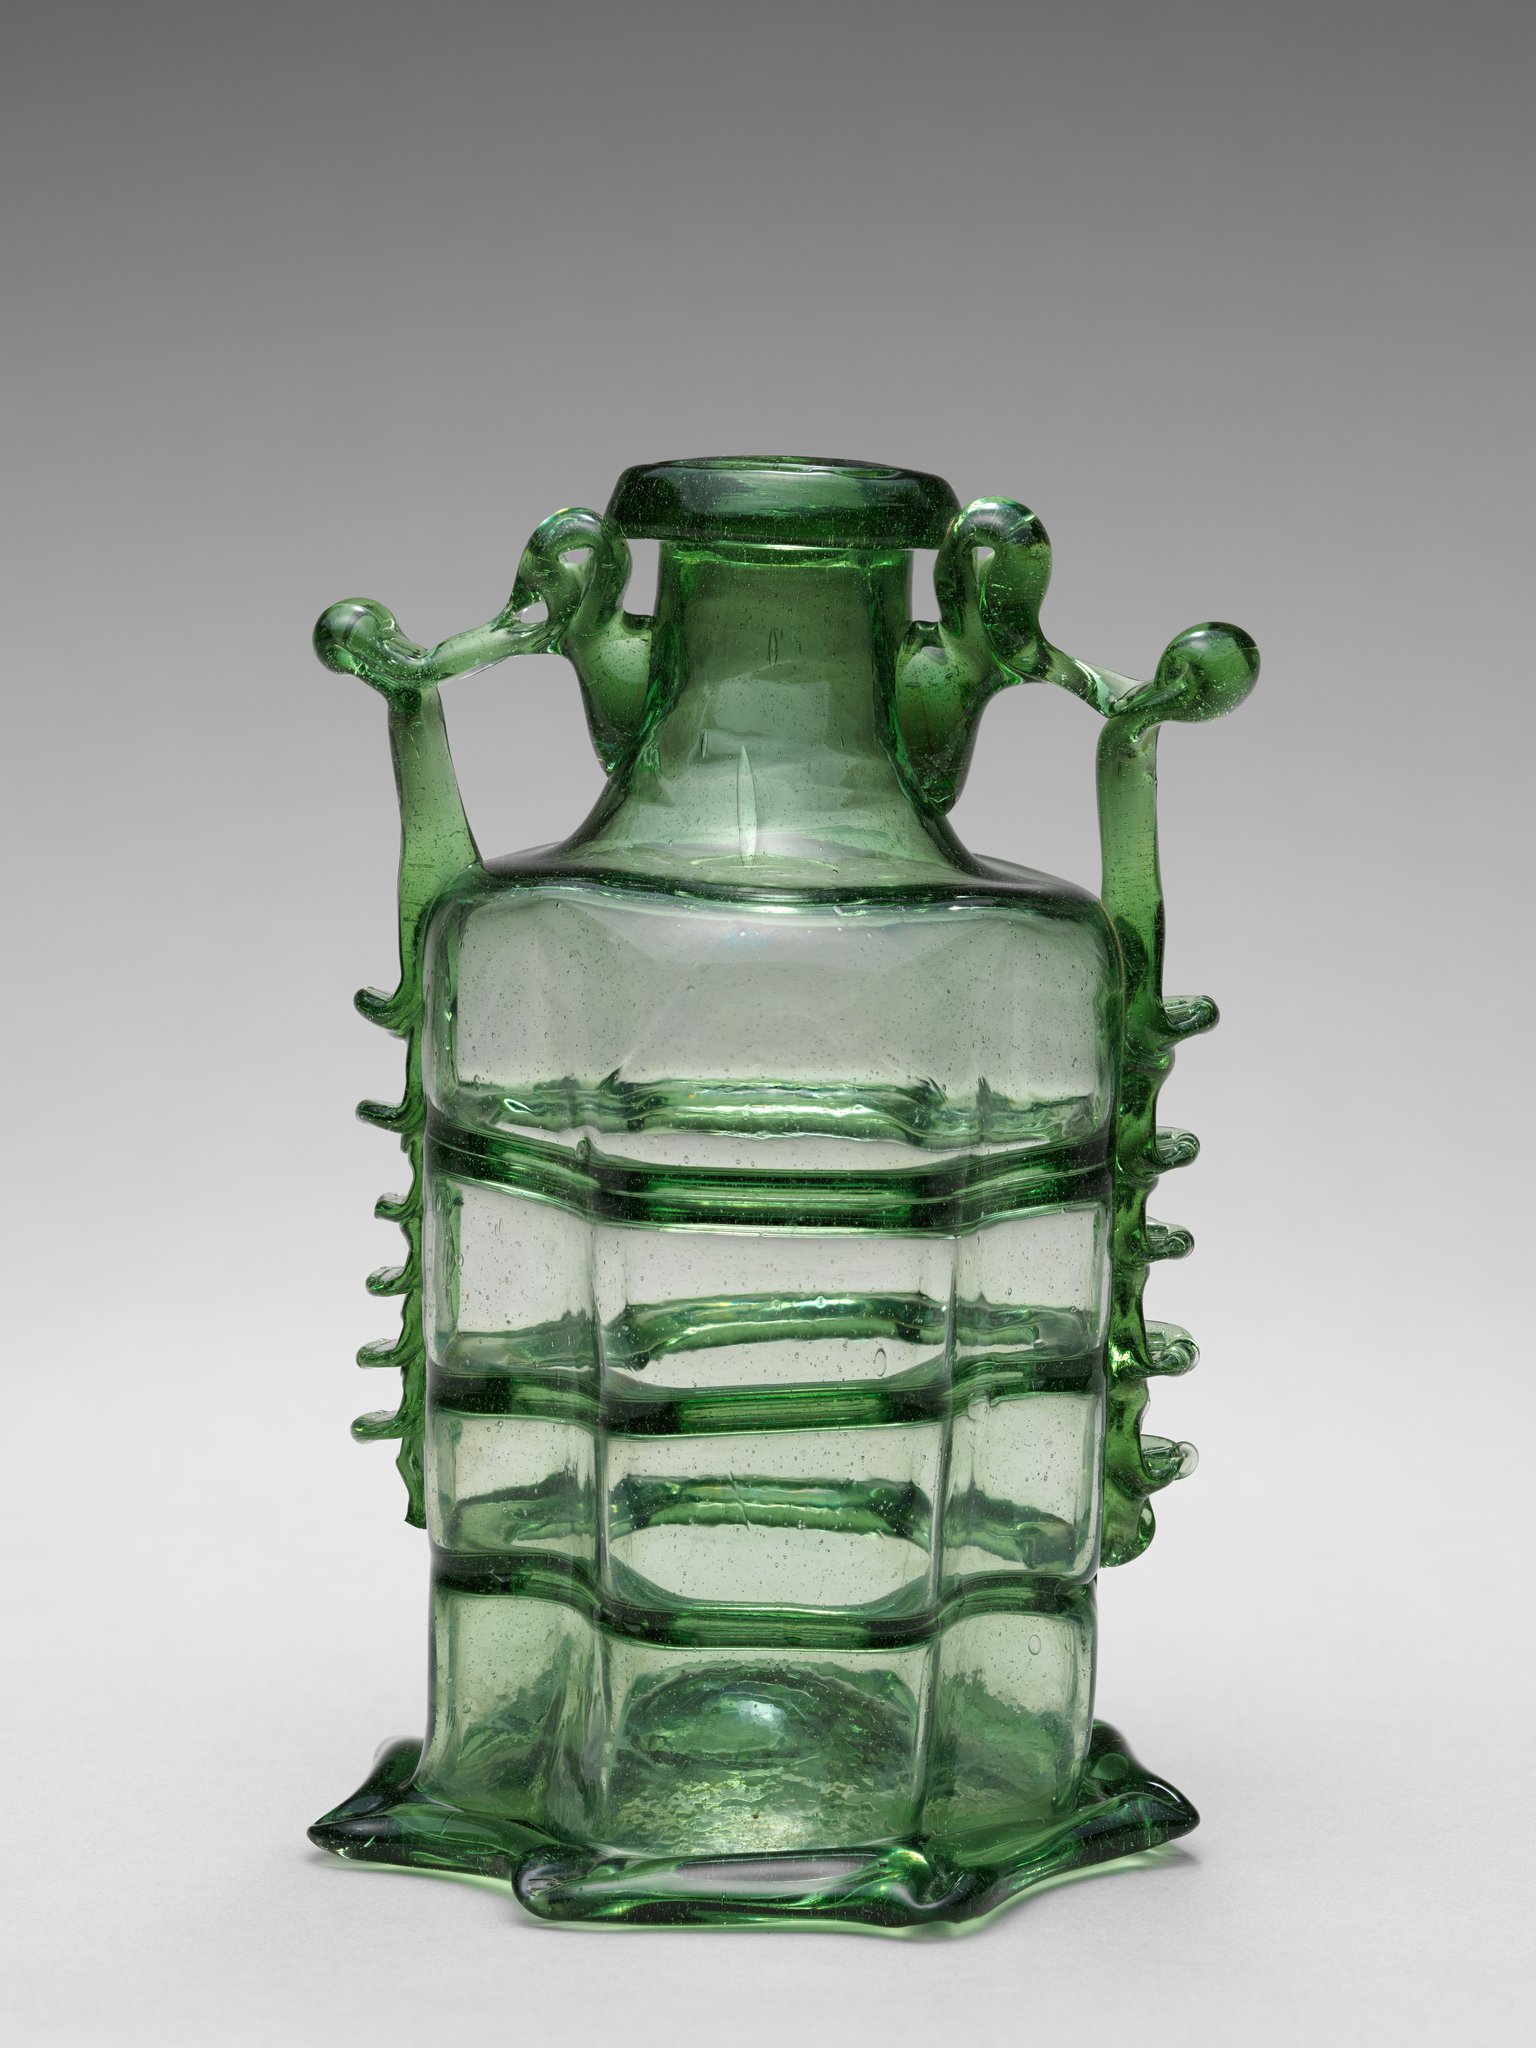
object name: bottle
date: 1601-1700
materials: glass